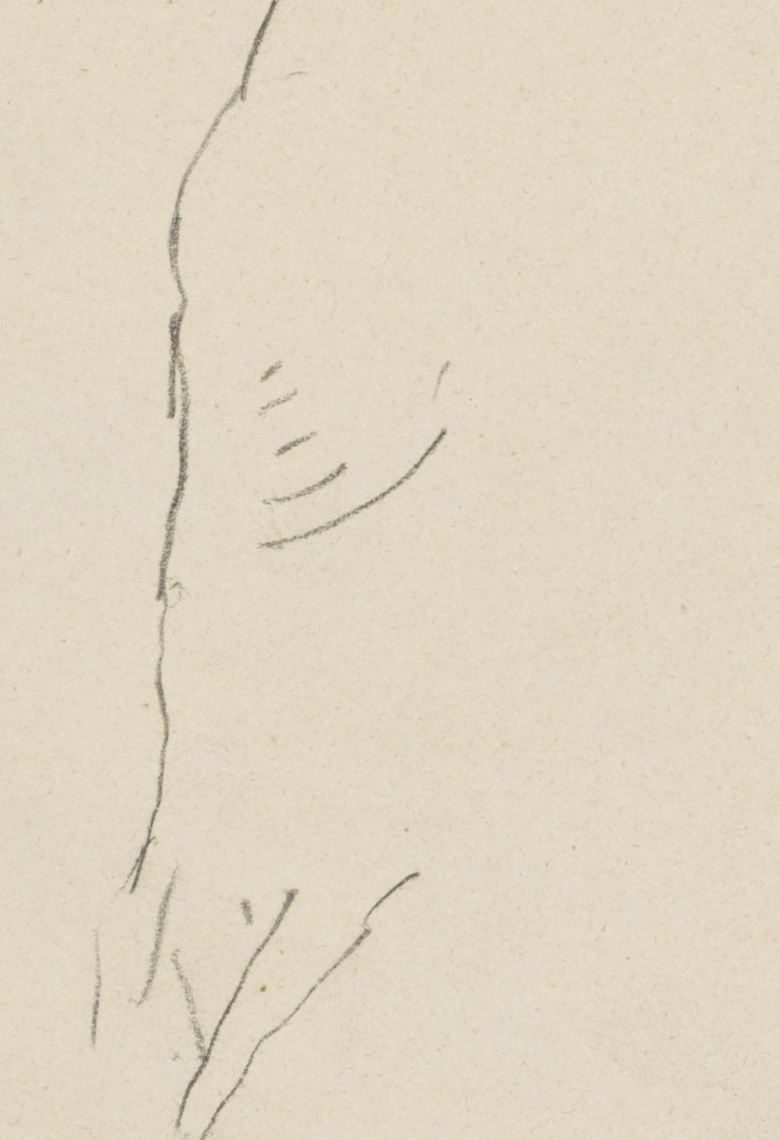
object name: sketchbook leaf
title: Studie, mogelijk van de rug van een paard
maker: george hendrik breitner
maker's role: draughtsman, painter, print maker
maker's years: 1857-1923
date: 1909-1912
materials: chalk, paper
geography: amsterdam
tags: horse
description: Studie, mogelijk van de rug van een paard. Pagina 8 uit een schetsboek met 46 bladen vervaardigd te Amsterdam.